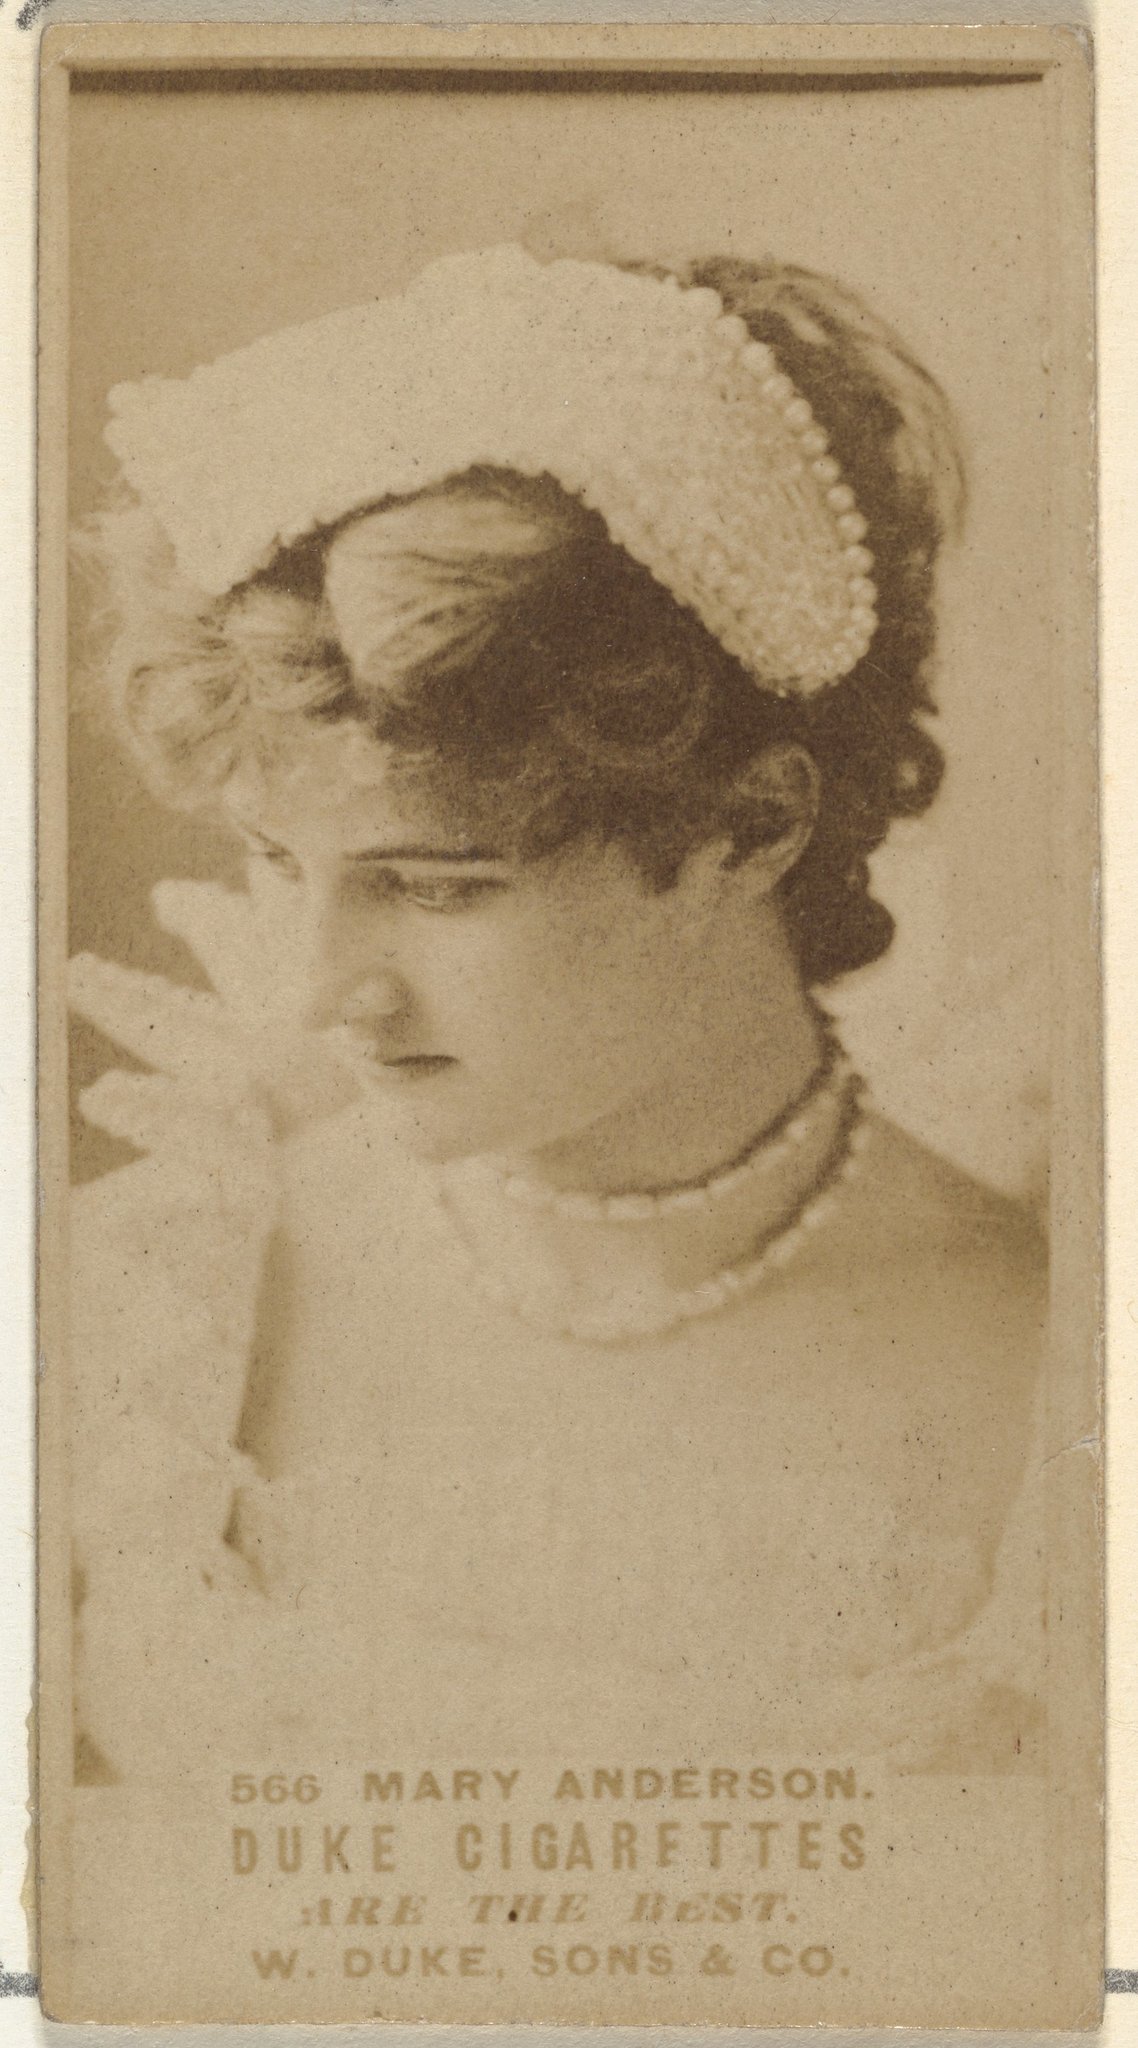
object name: photograph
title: Card Number 566, Mary Anderson, from the Actors and Actresses series (N145-7) issued by Duke Sons & Co. to promote Duke Cigarettes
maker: w. duke, sons & co.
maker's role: publisher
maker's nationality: american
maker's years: 1870-1920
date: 1880-1889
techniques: albumen silver print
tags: portraits,women,actresses